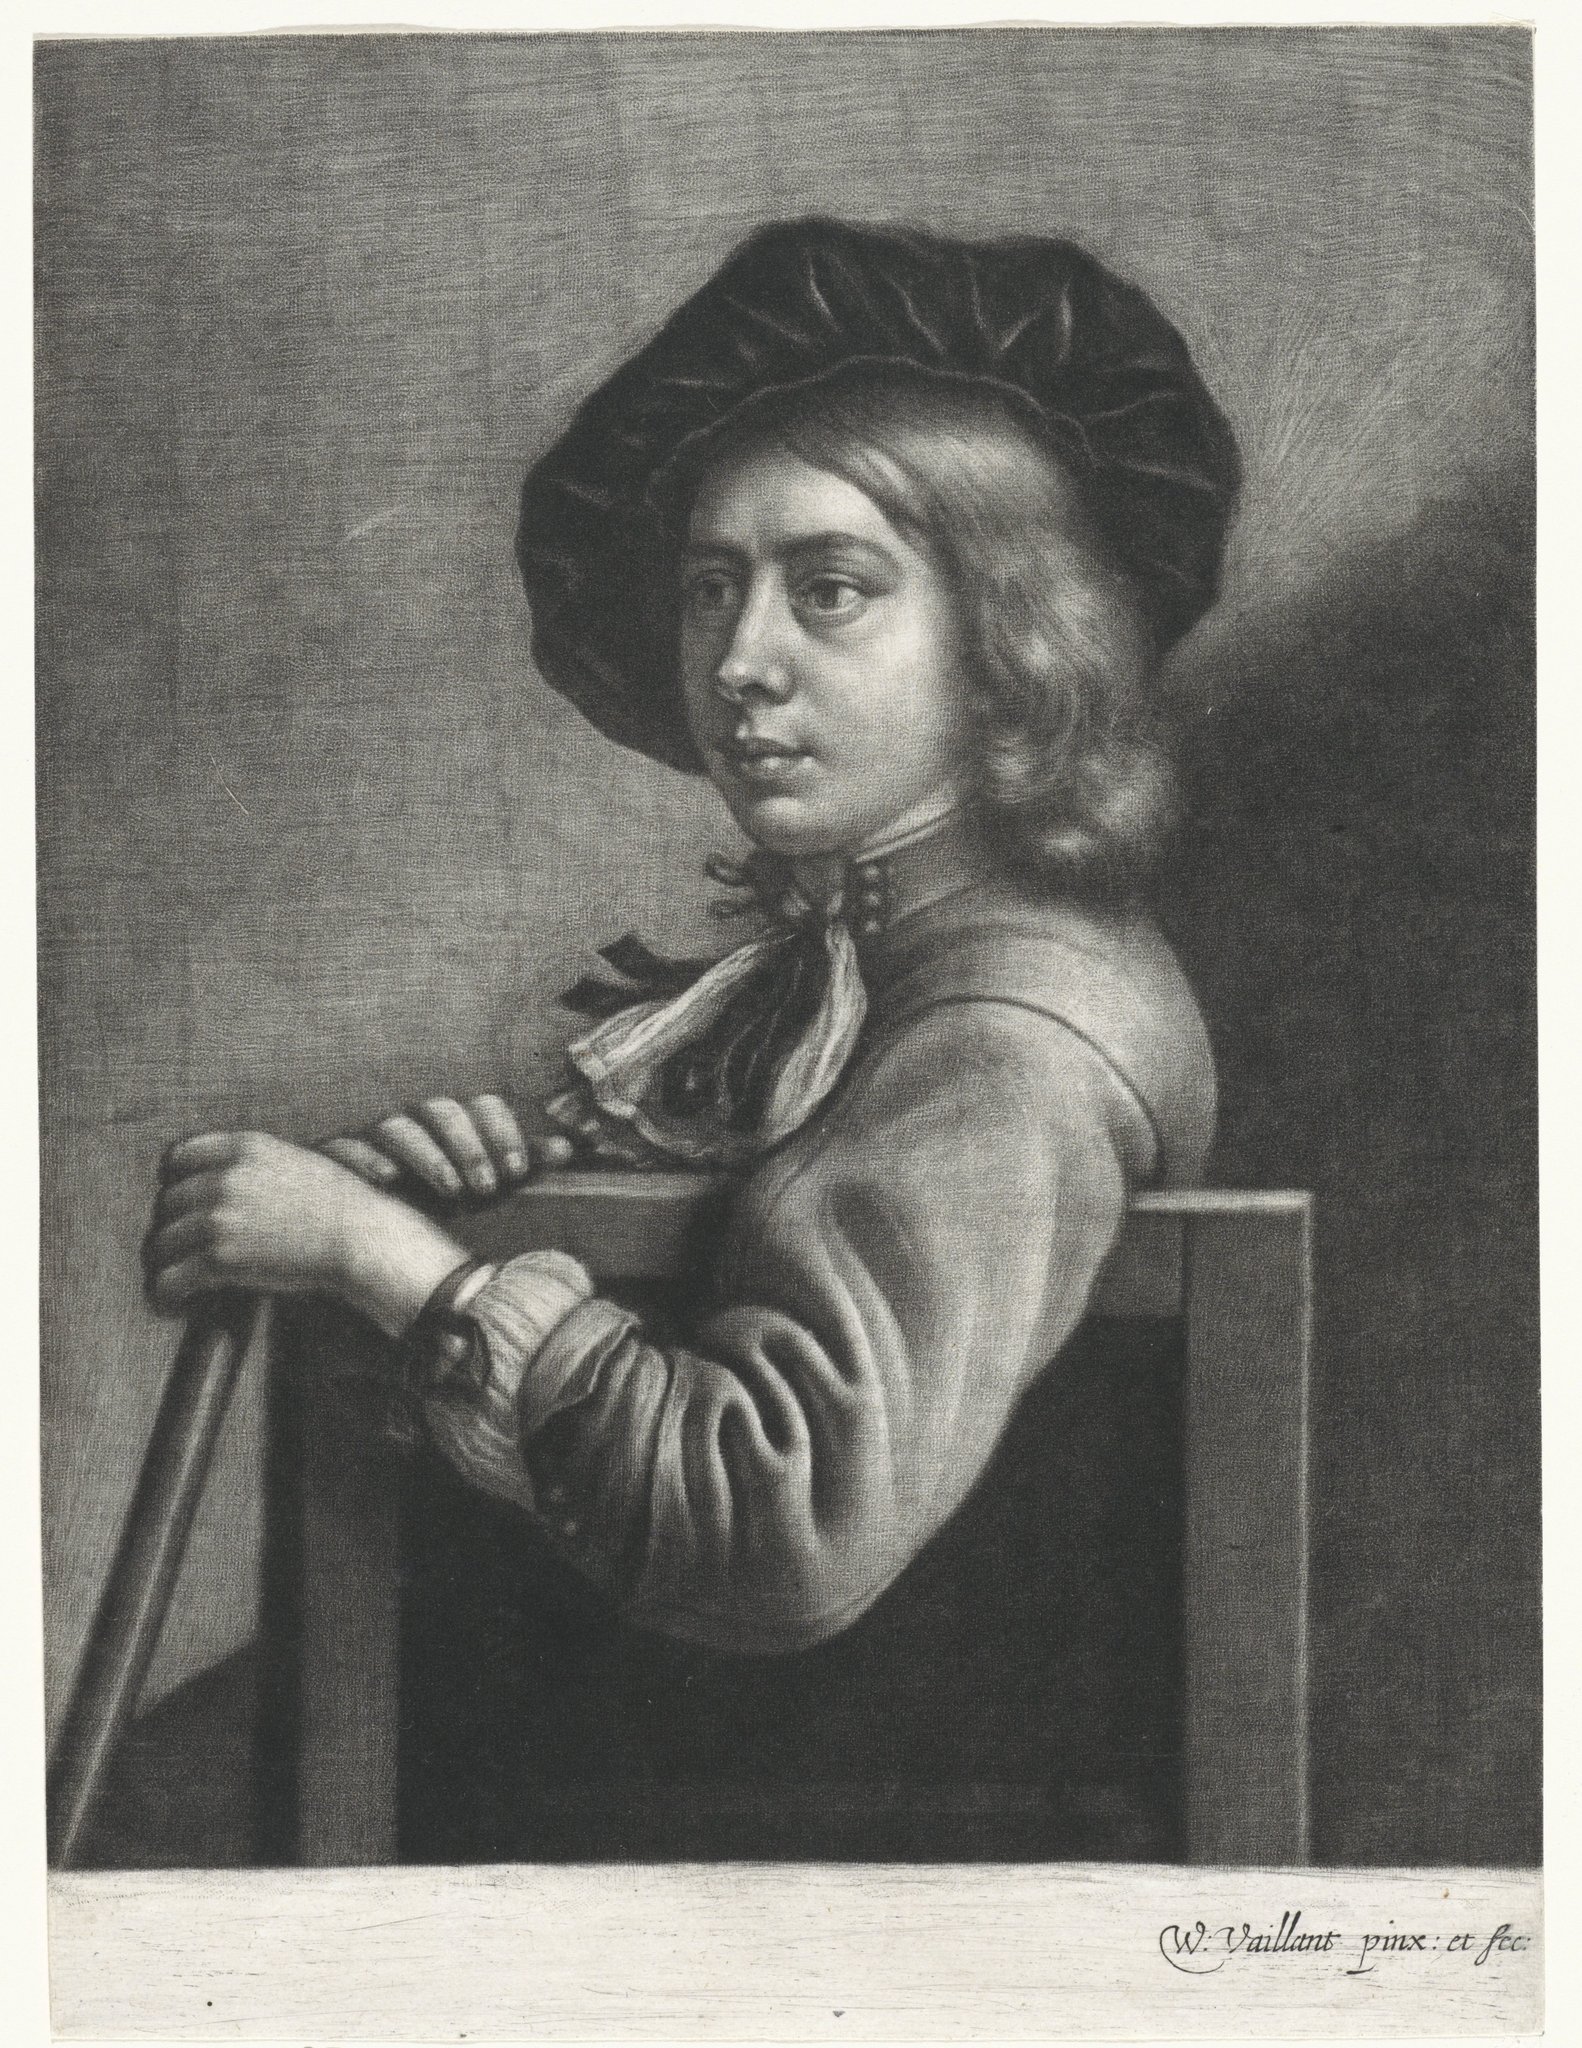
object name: print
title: Zittende jongen met een baret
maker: wallerant vaillant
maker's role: draughtsman, painter, print maker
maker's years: 1623-1677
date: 1658-1677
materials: paper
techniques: mezzotint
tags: head-gear: beret (+ men's clothes)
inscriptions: collector's mark: Lugt 240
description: Een jongen met een baret zit op een stoel. In zijn hand een stok.